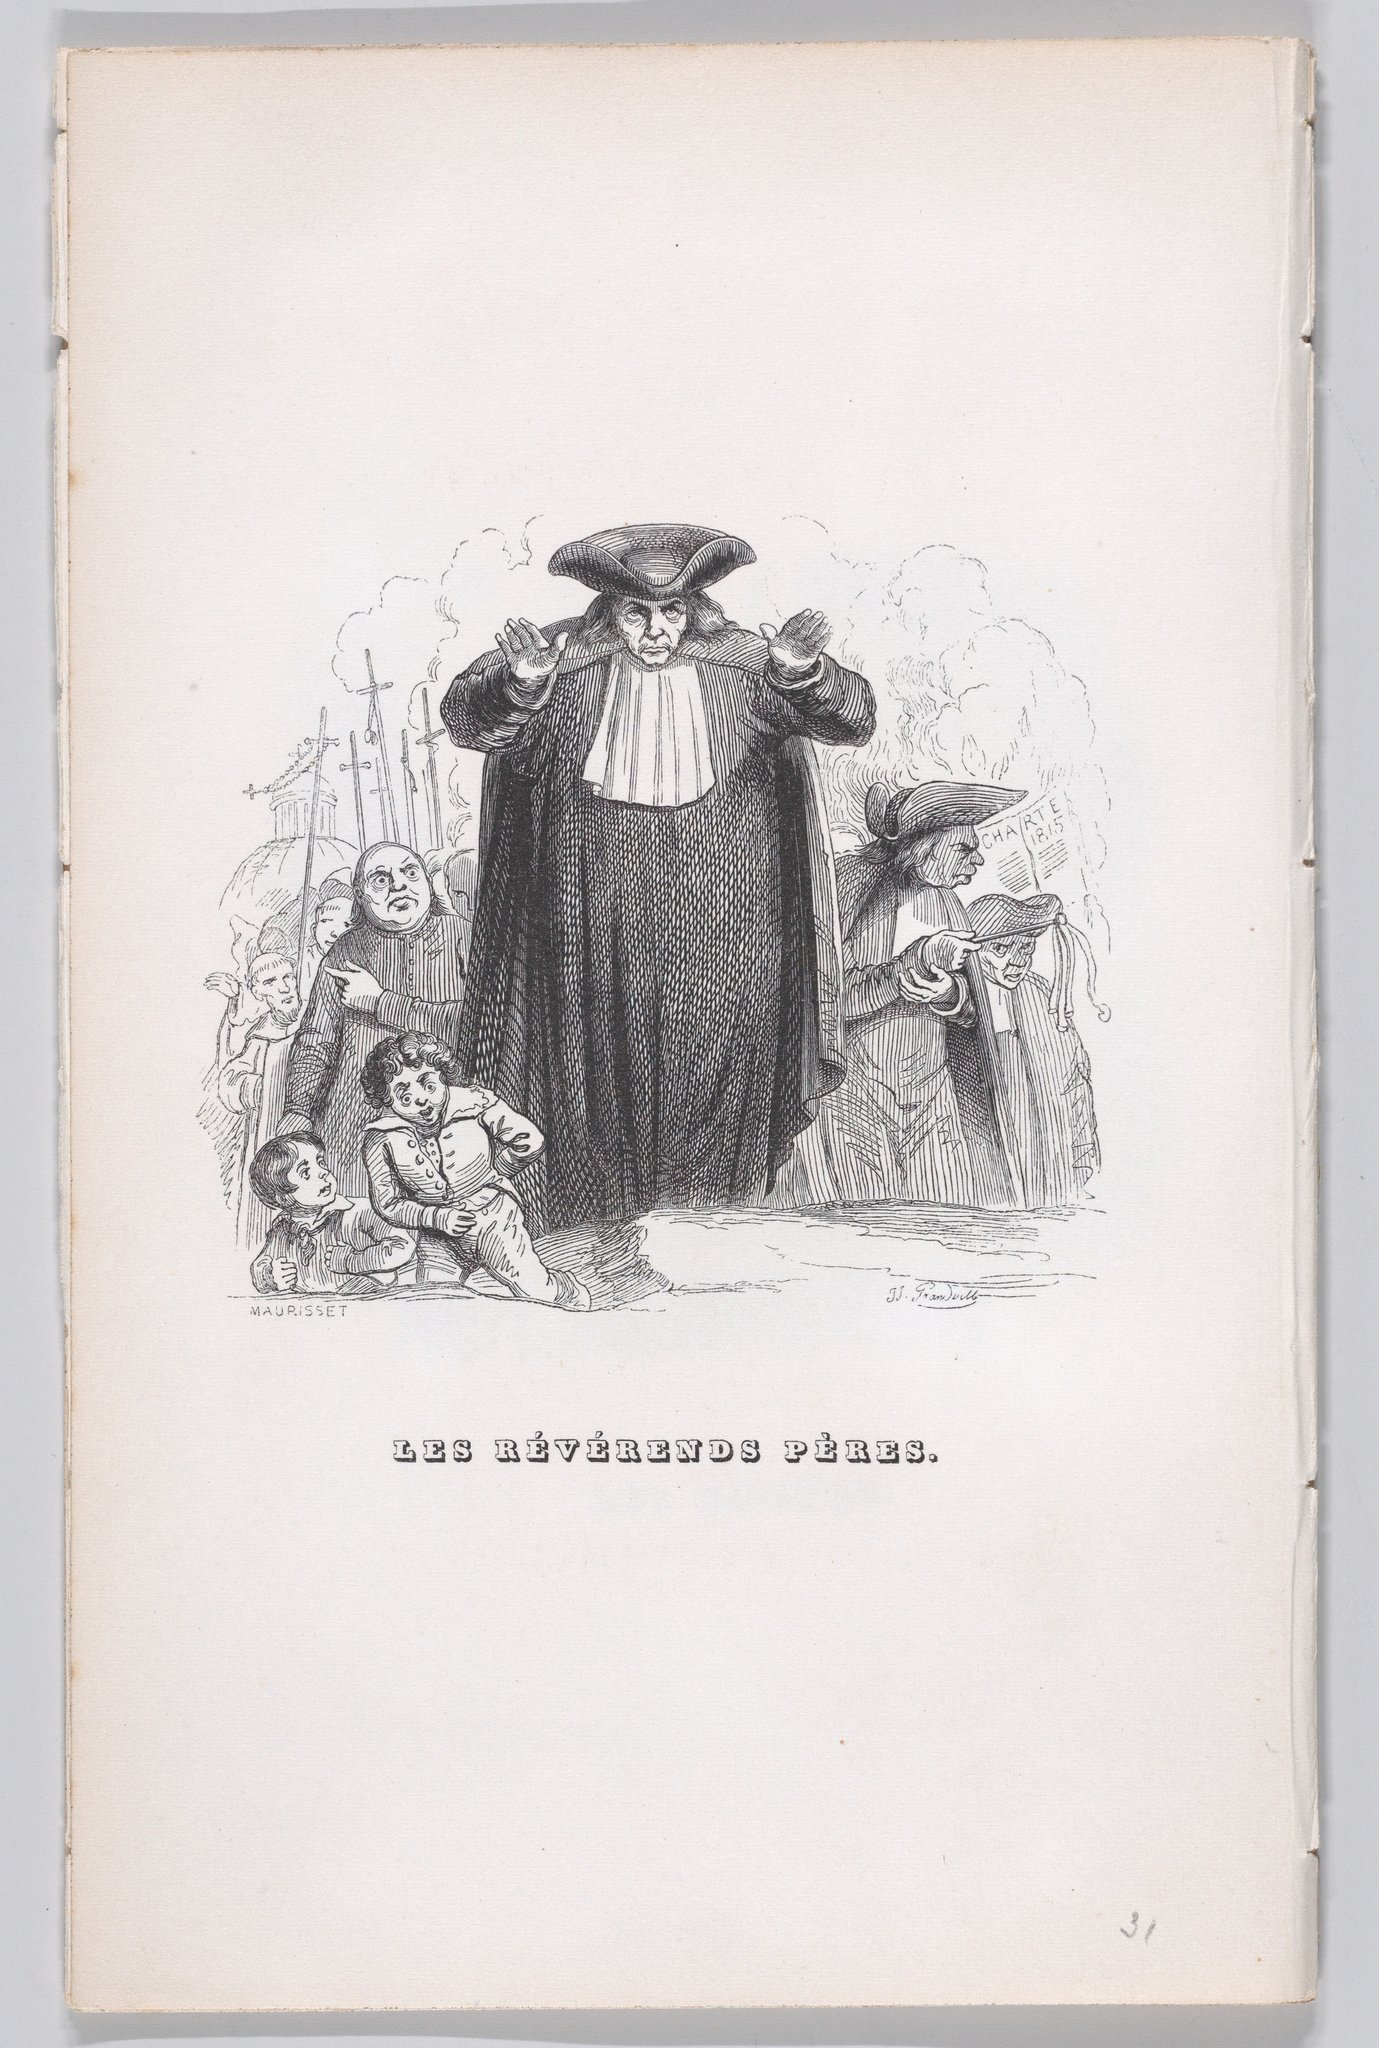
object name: print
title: The Reverend Fathers, from "The Complete Works of Béranger"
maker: j. j. grandville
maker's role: illustrator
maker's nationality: french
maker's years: 1803-1847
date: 1836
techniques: engraving